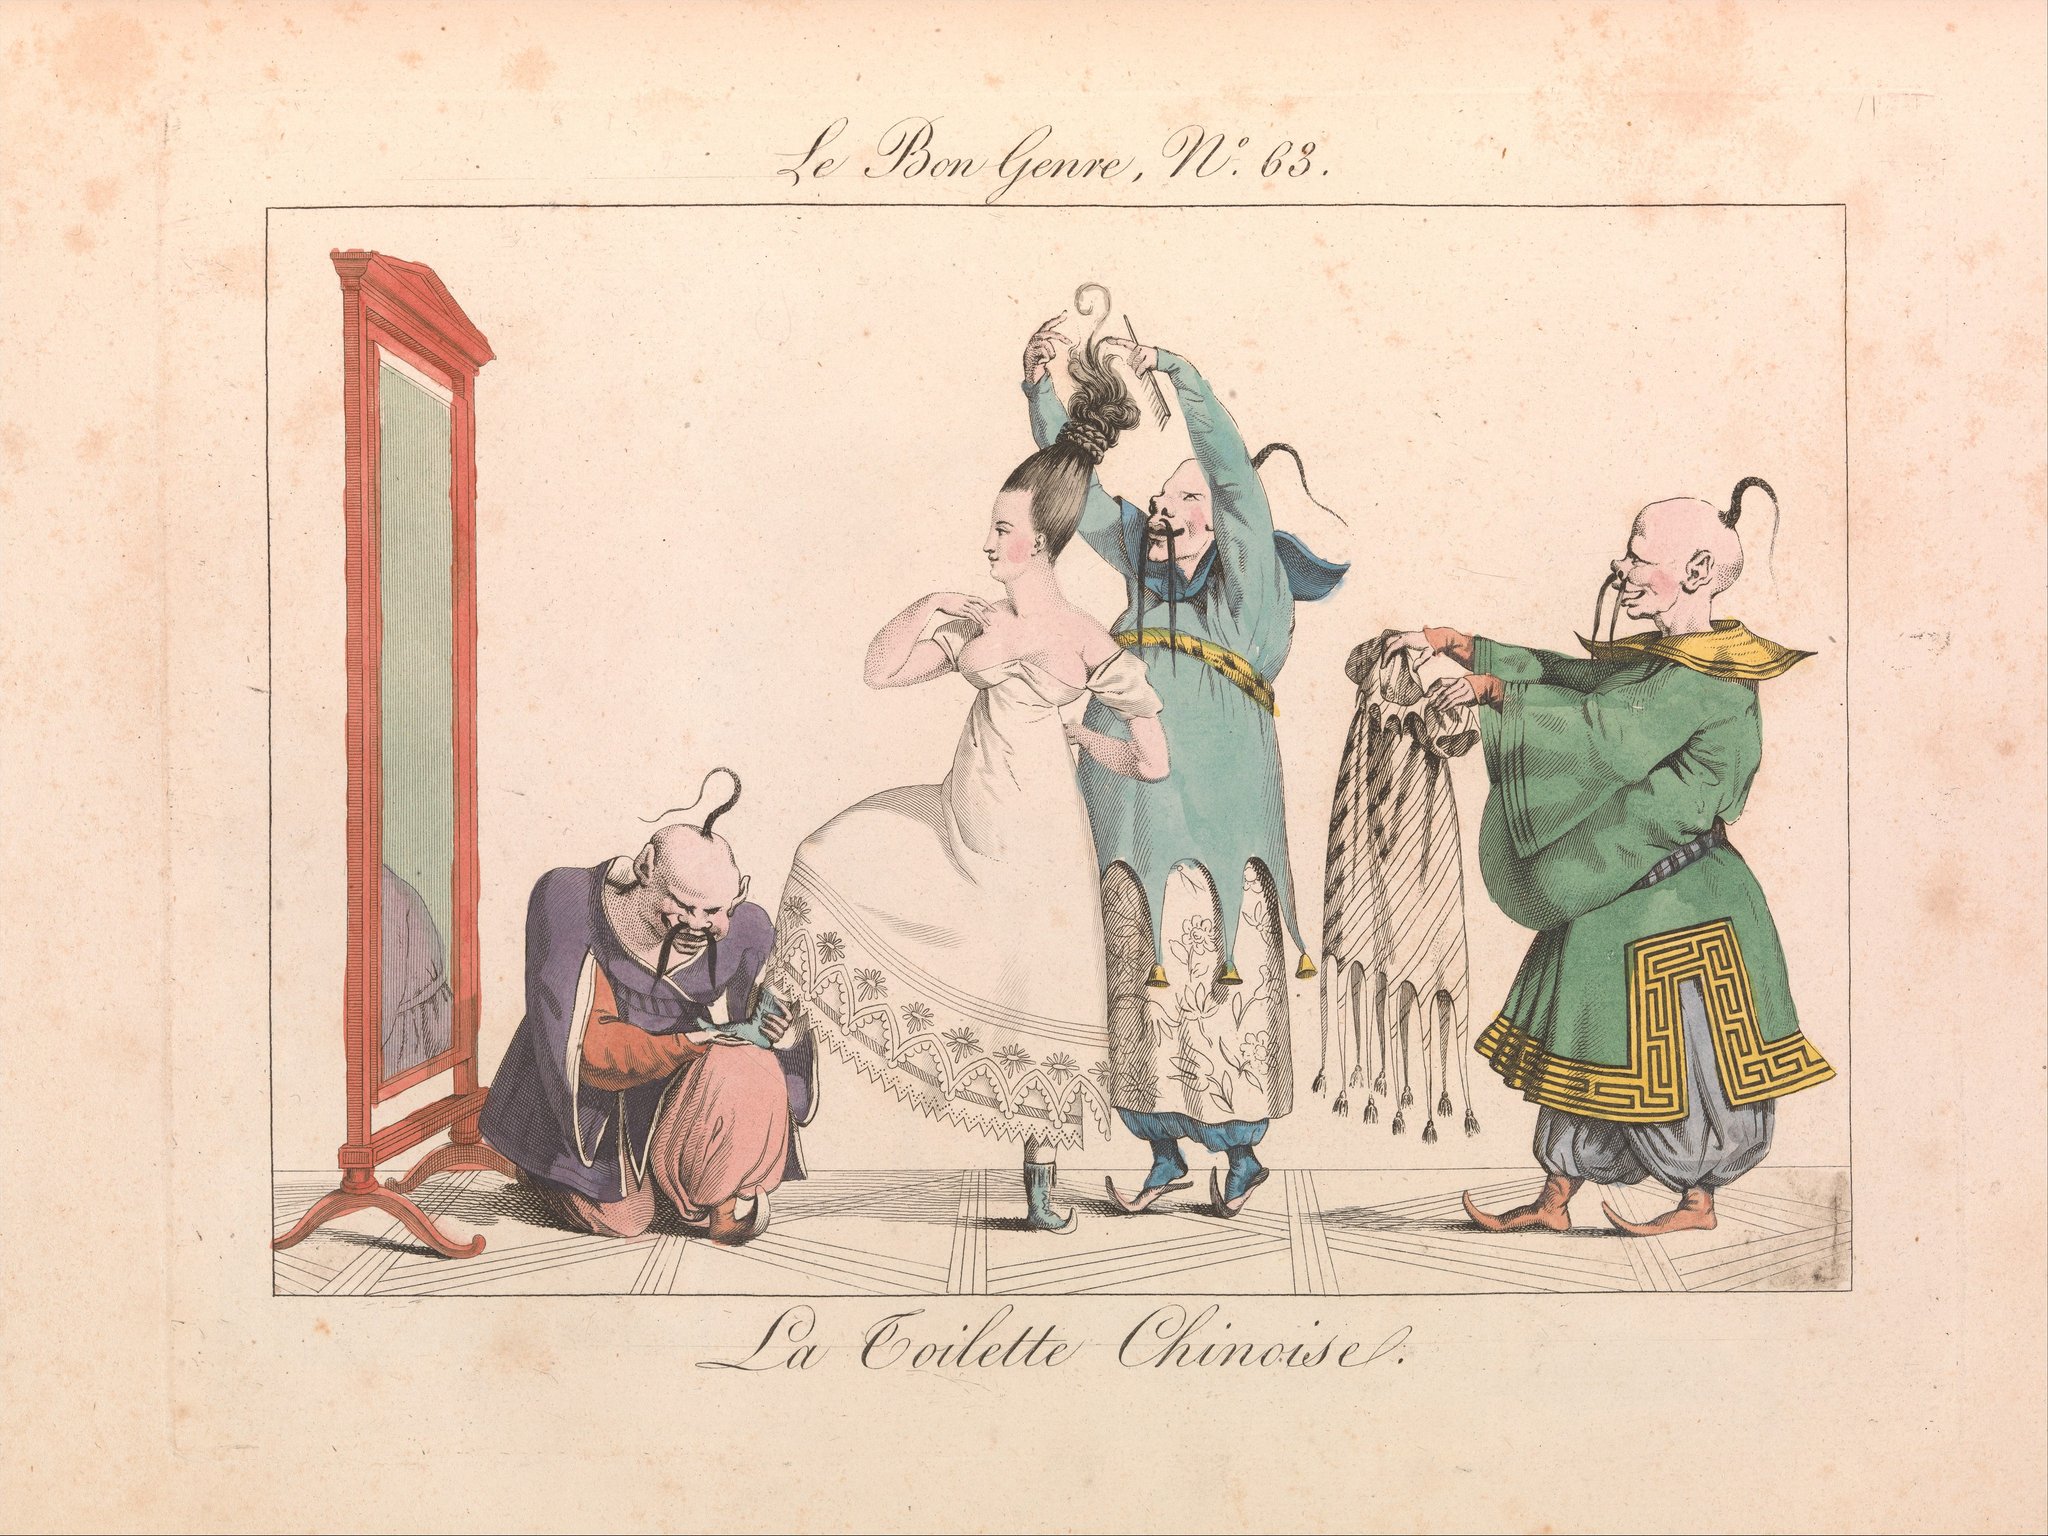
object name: book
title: Le Bon Genre: Observations sur les modes et les usages de Paris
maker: la messangère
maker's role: publisher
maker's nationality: french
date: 1827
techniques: engraving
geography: france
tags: hair,men,women,dressing,mirrors